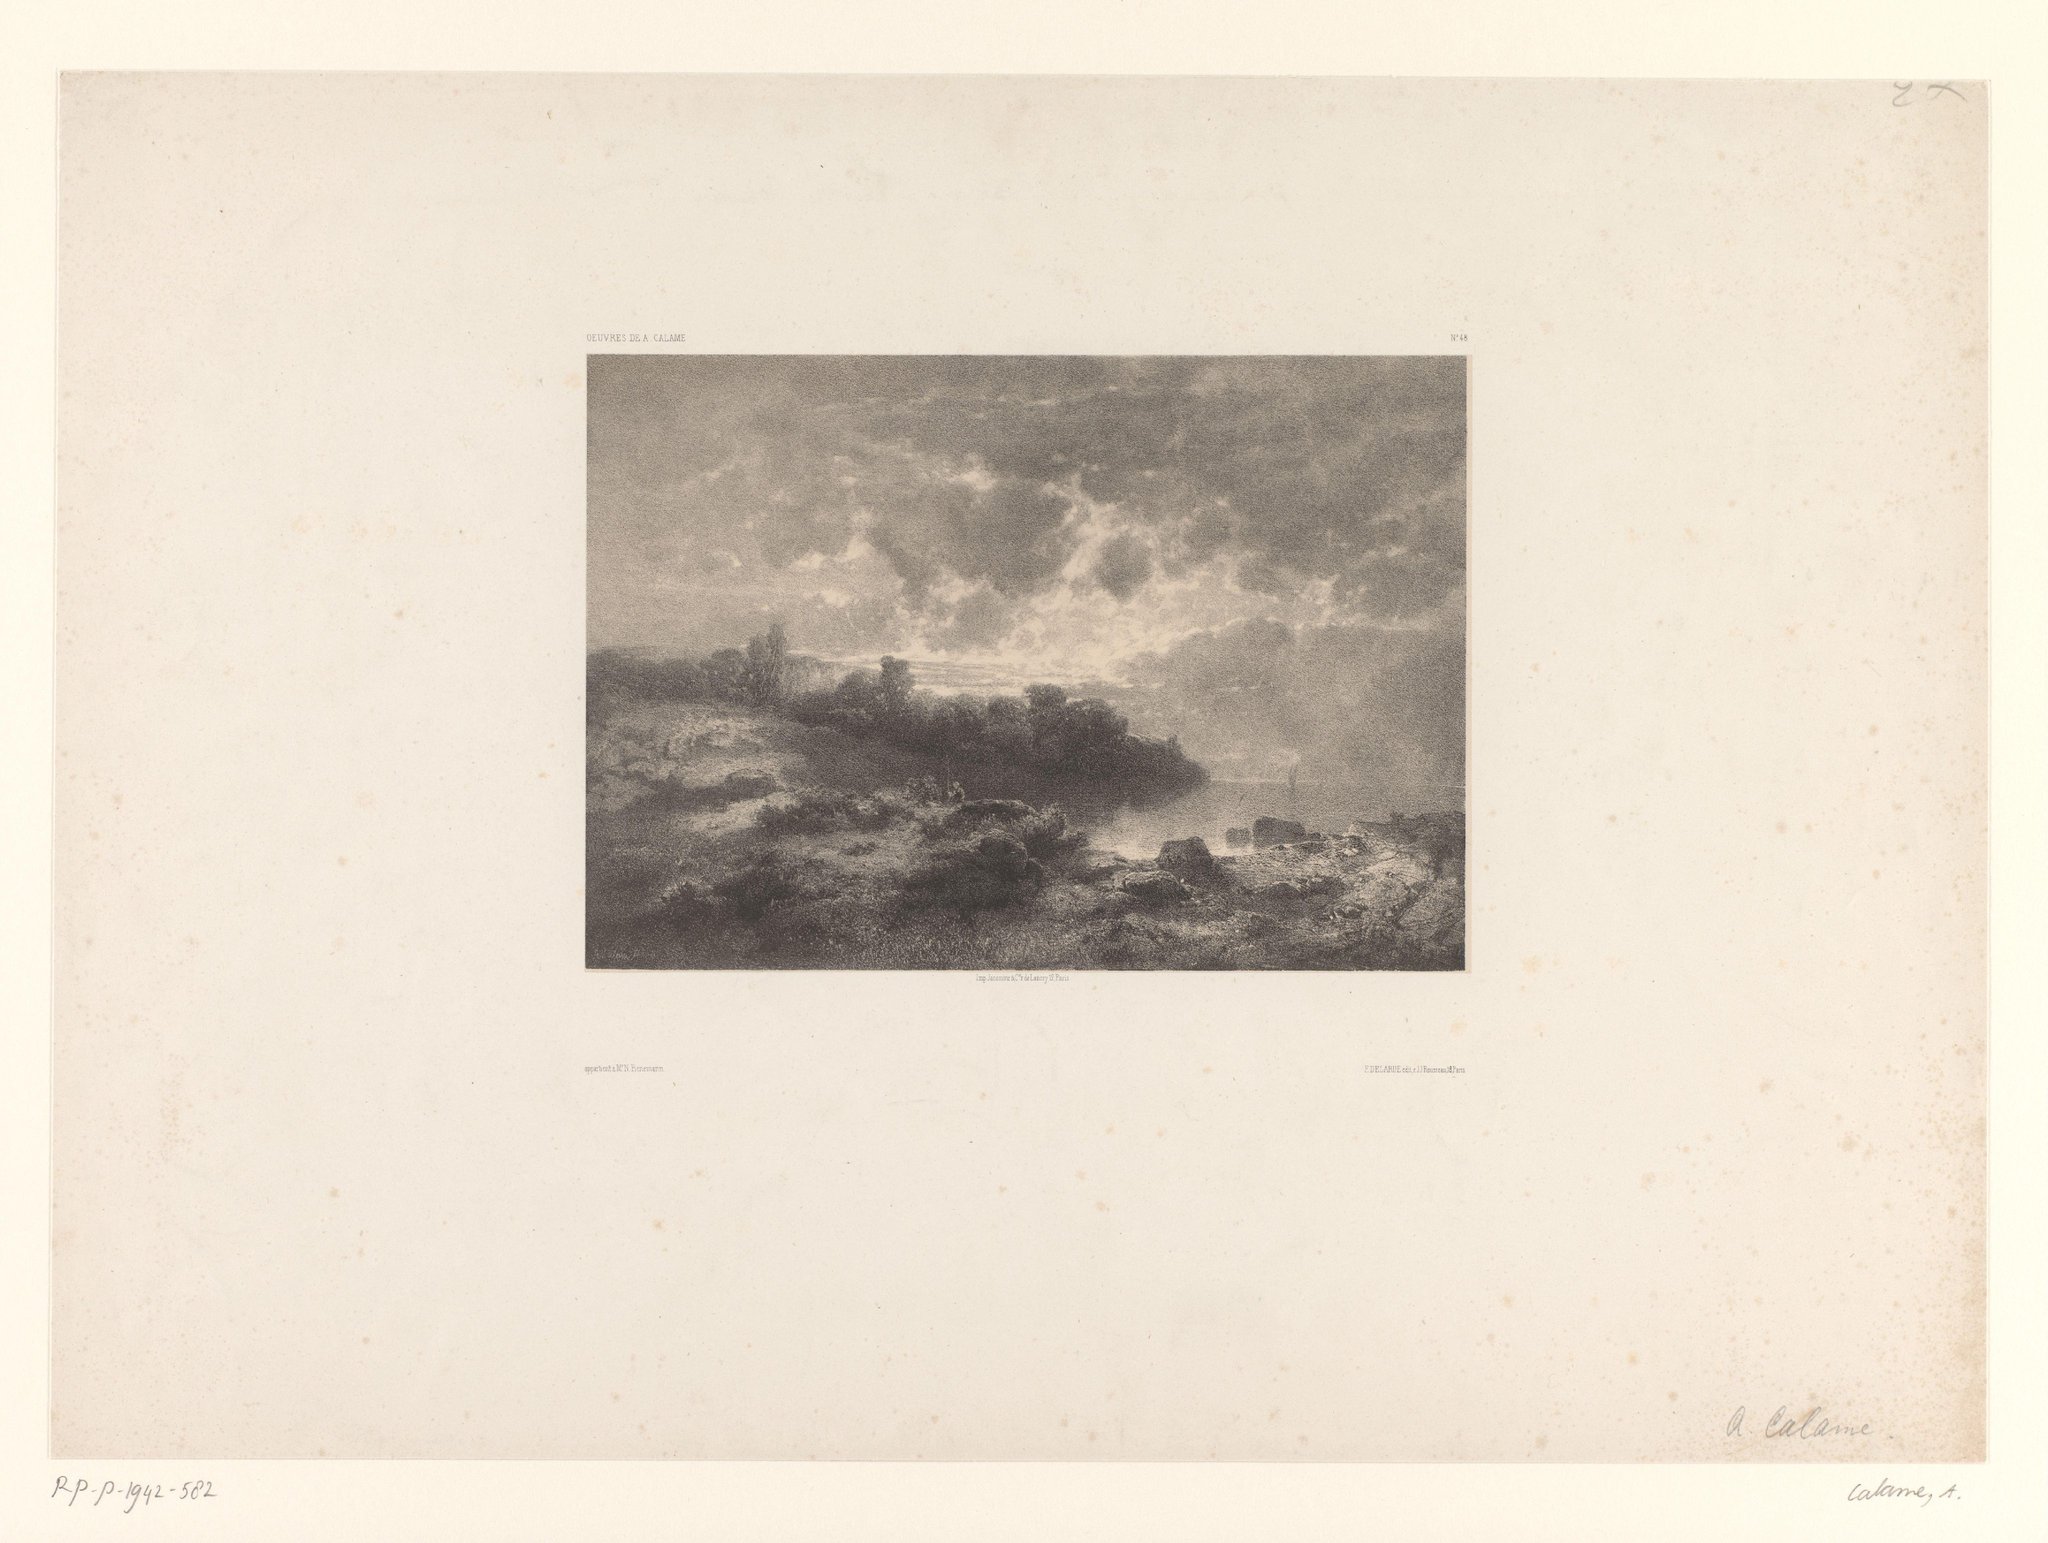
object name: print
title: Landschap met meer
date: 1852-1855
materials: paper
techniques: lithograph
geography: paris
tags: low hill country (+ landscape with figures, staffage), lake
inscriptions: collector's mark: Lugt 2228a